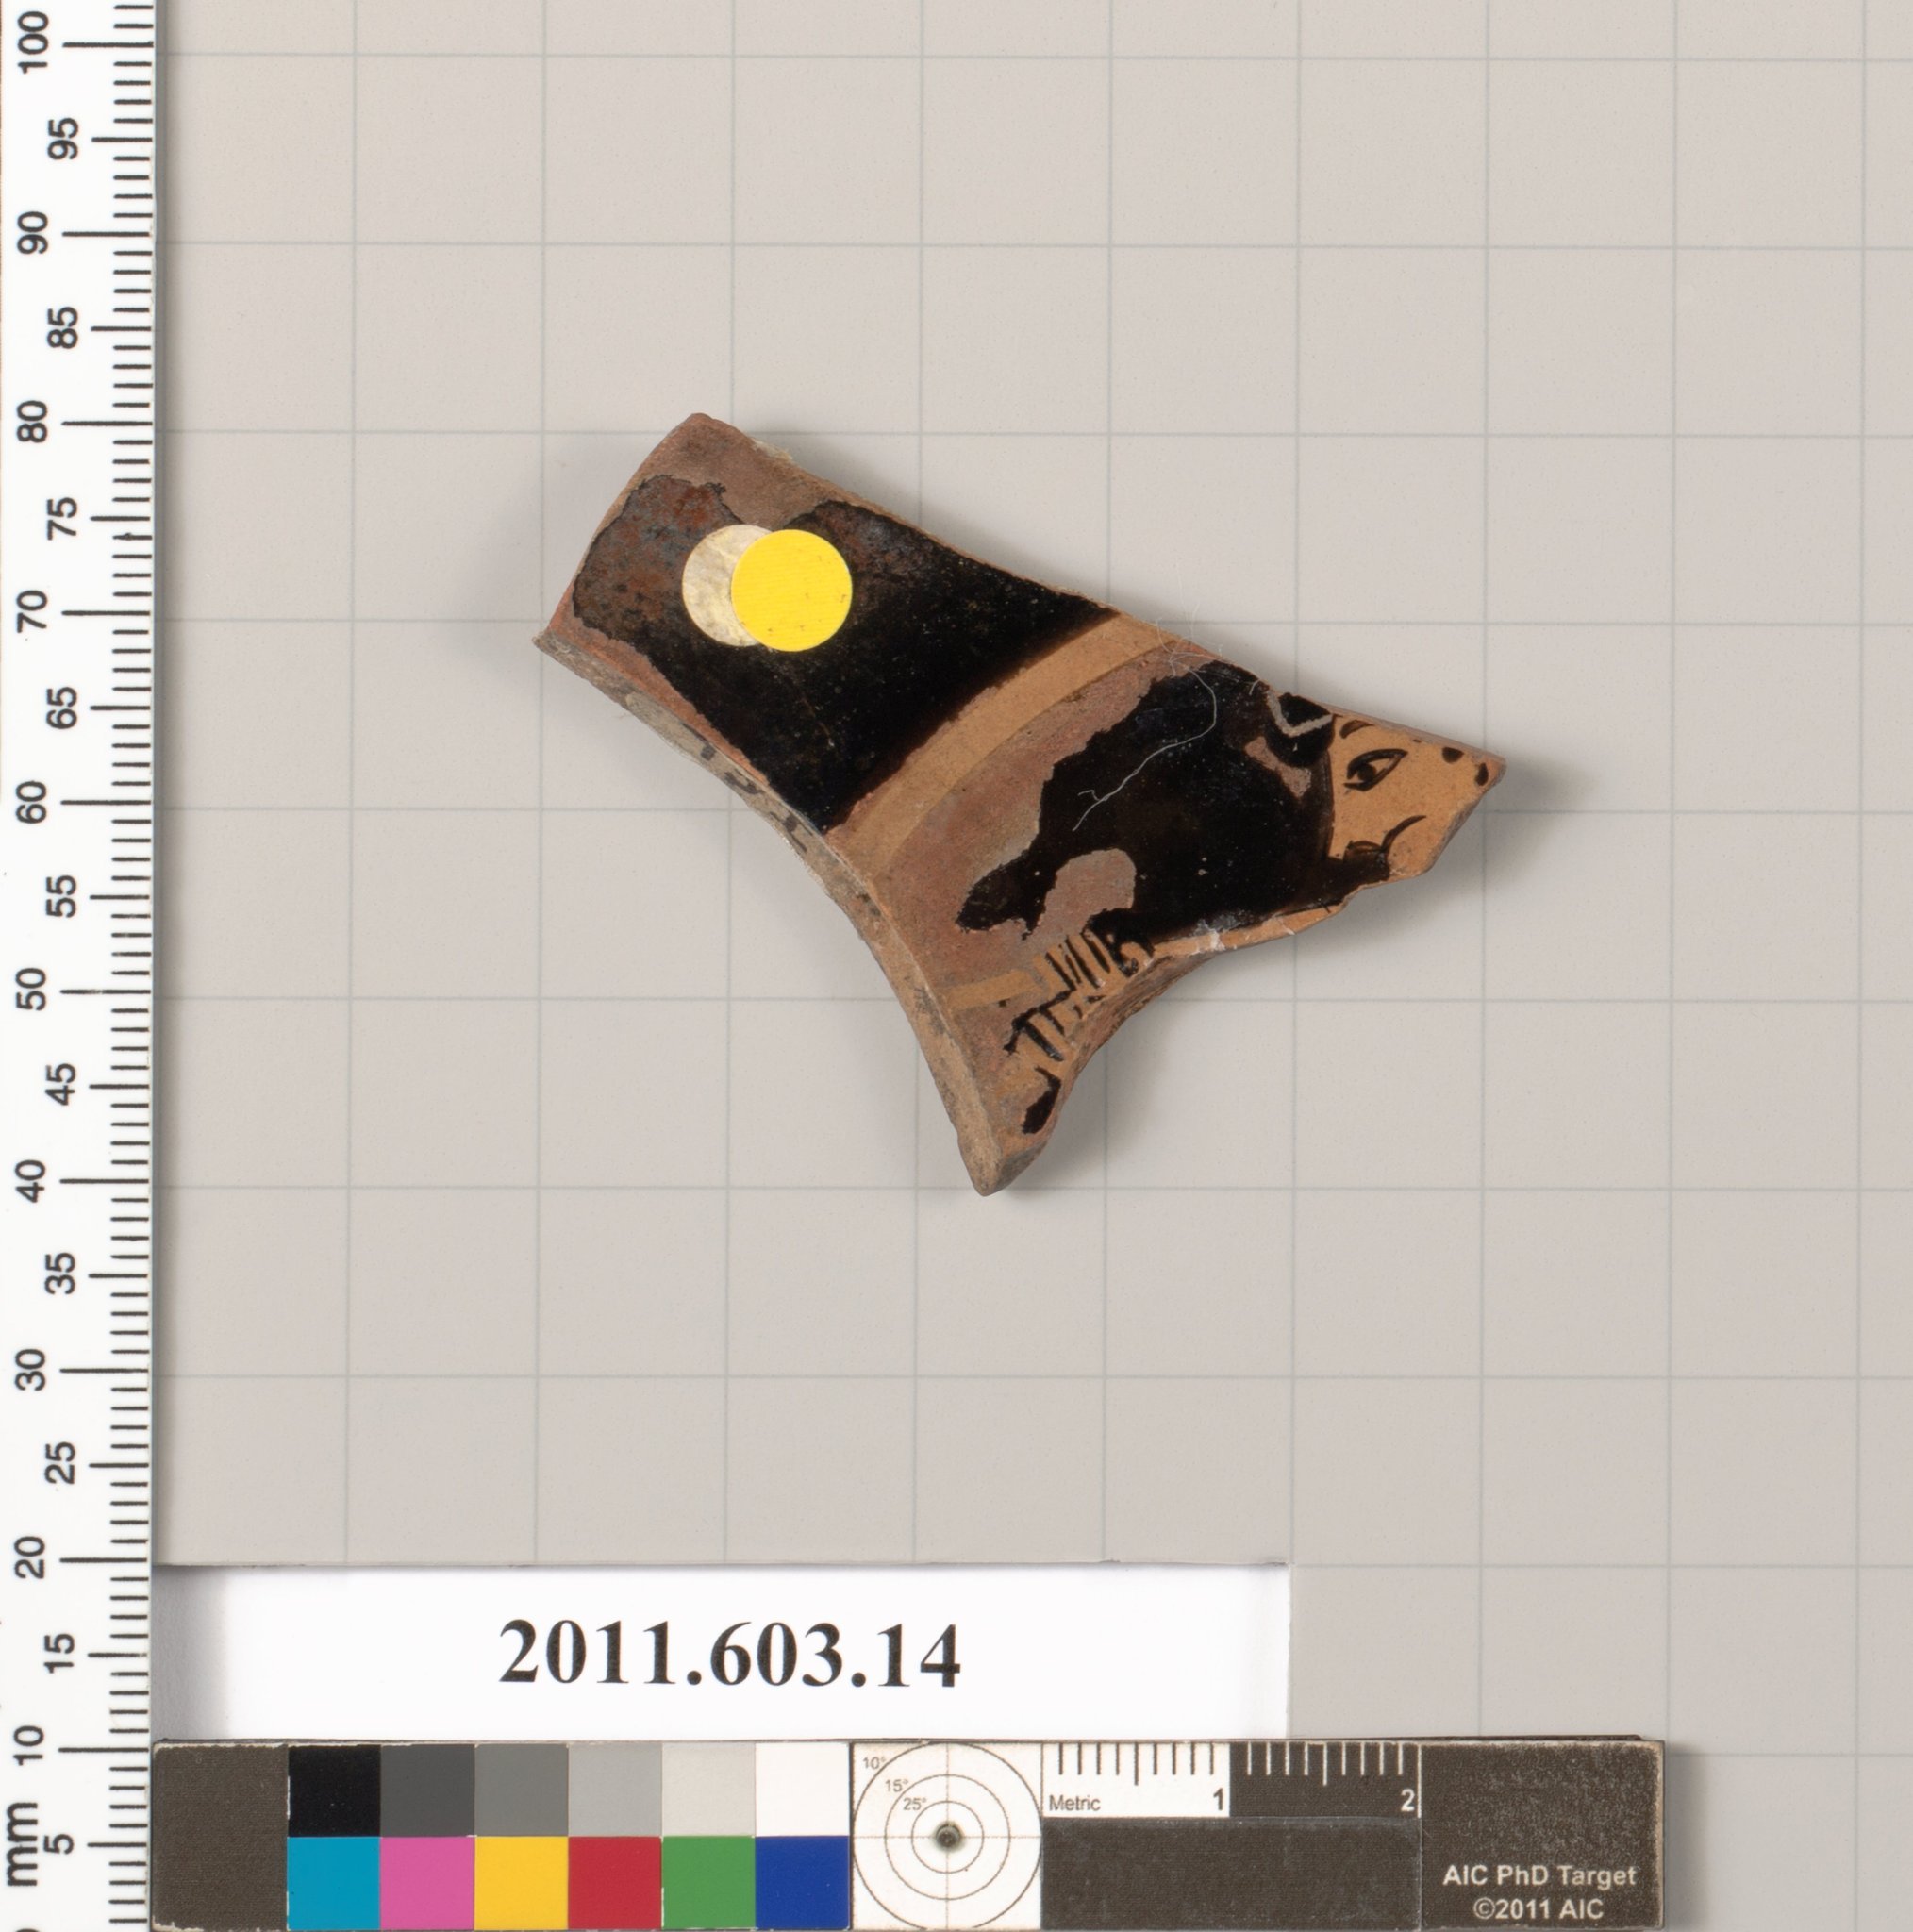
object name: kylix fragment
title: Fragment of a terracotta kylix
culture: greek, attic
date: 500-476 BCE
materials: terracotta